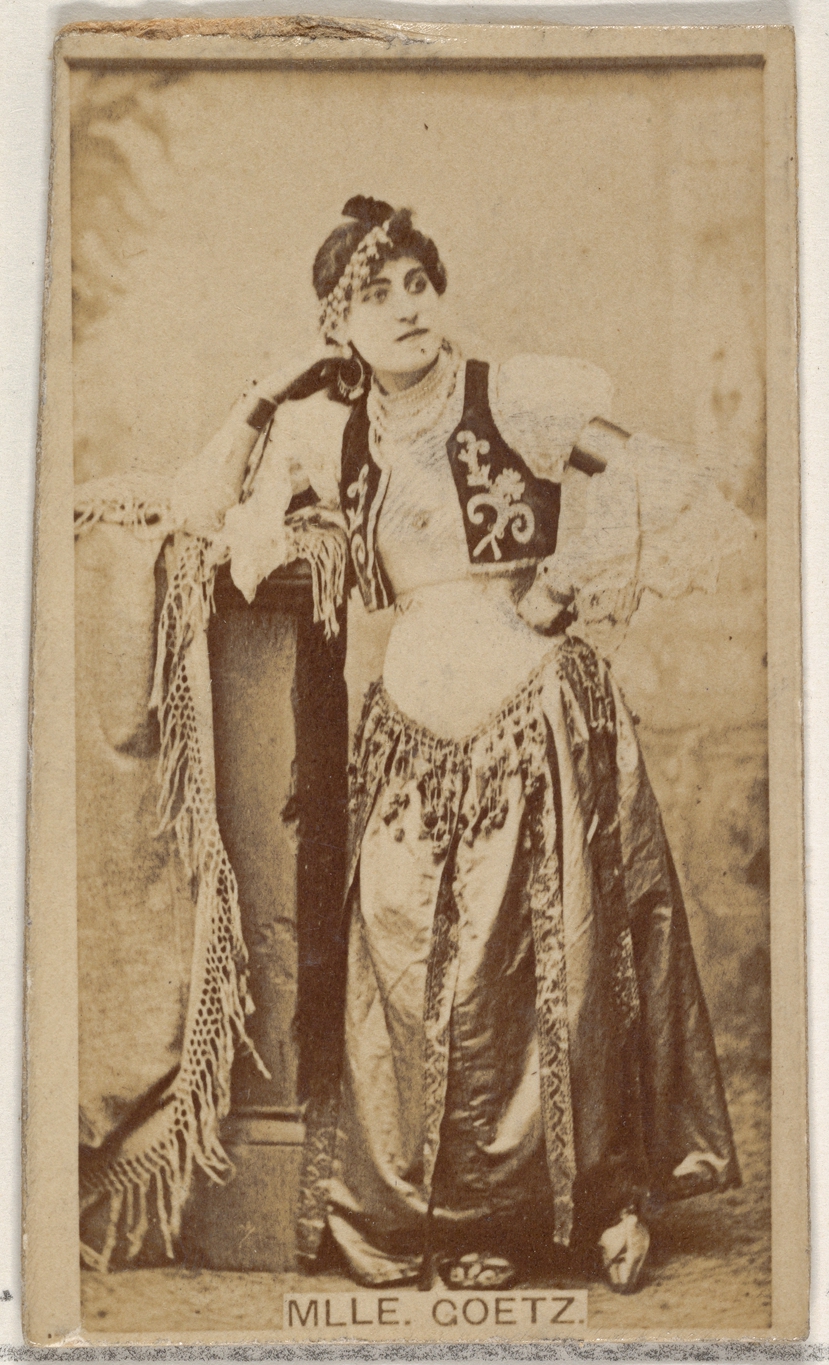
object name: photograph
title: Mlle. Goetz, from the Actors and Actresses series (N45, Type 8) for Virginia Brights Cigarettes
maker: allen & ginter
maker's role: publisher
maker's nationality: american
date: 1888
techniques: albumen silver print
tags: portraits,women,actresses